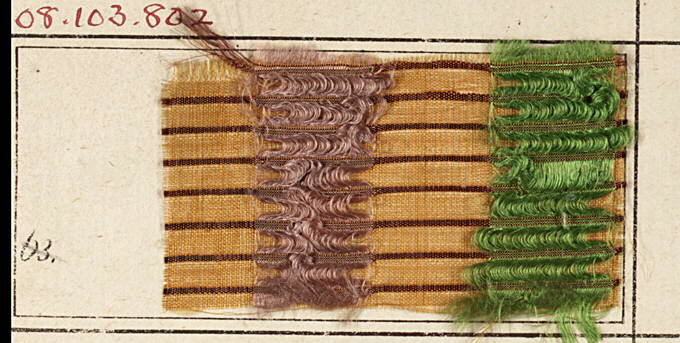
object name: ribbon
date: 1701-1900